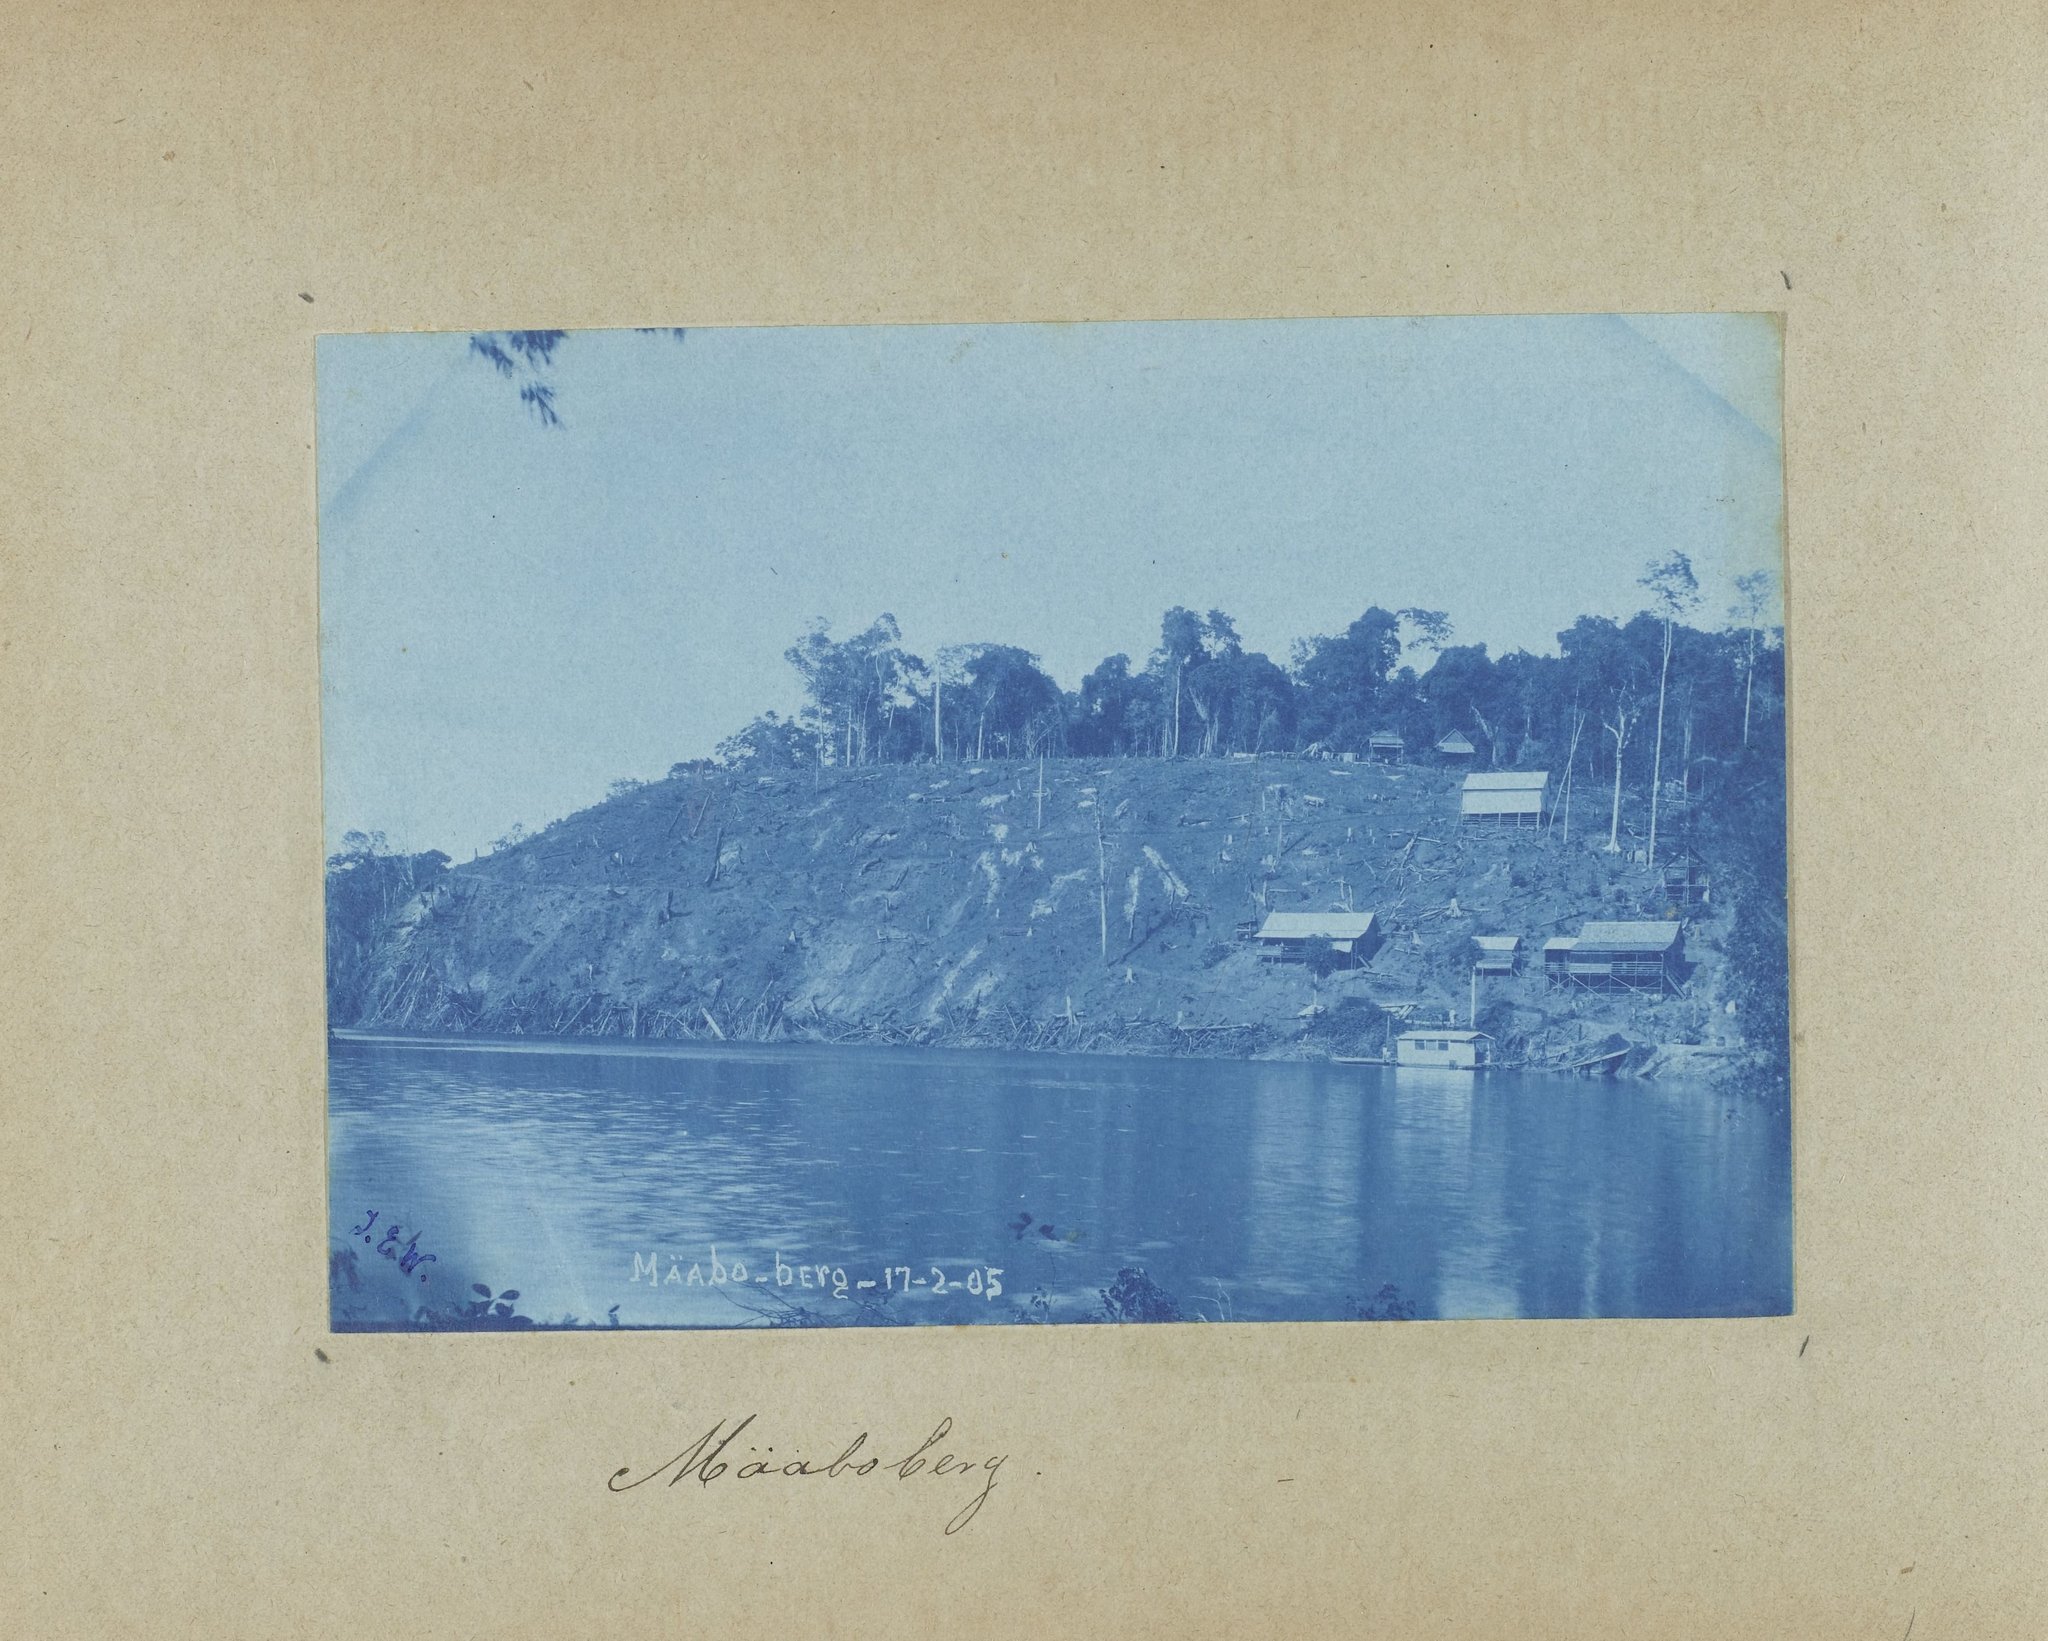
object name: photograph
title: Mäabo-berg 17-02-05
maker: jacob evert wesenhagen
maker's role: amateurfotograaf, arts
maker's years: 1862-1924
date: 1905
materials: photographic support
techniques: cyanotype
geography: suriname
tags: jacob evert wesenhagen, railway, tramway; rack railway, suriname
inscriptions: inscription: ‘Mäaboberg’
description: Gezicht op de Maäbo Heuvel. Foto in het fotoalbum over de aanleg van de Lawaspoorweg in Suriname in de jaren 1903-1912. Onderdeel van een groep objecten afkomstig van de familie Wesenhagen in Suriname.